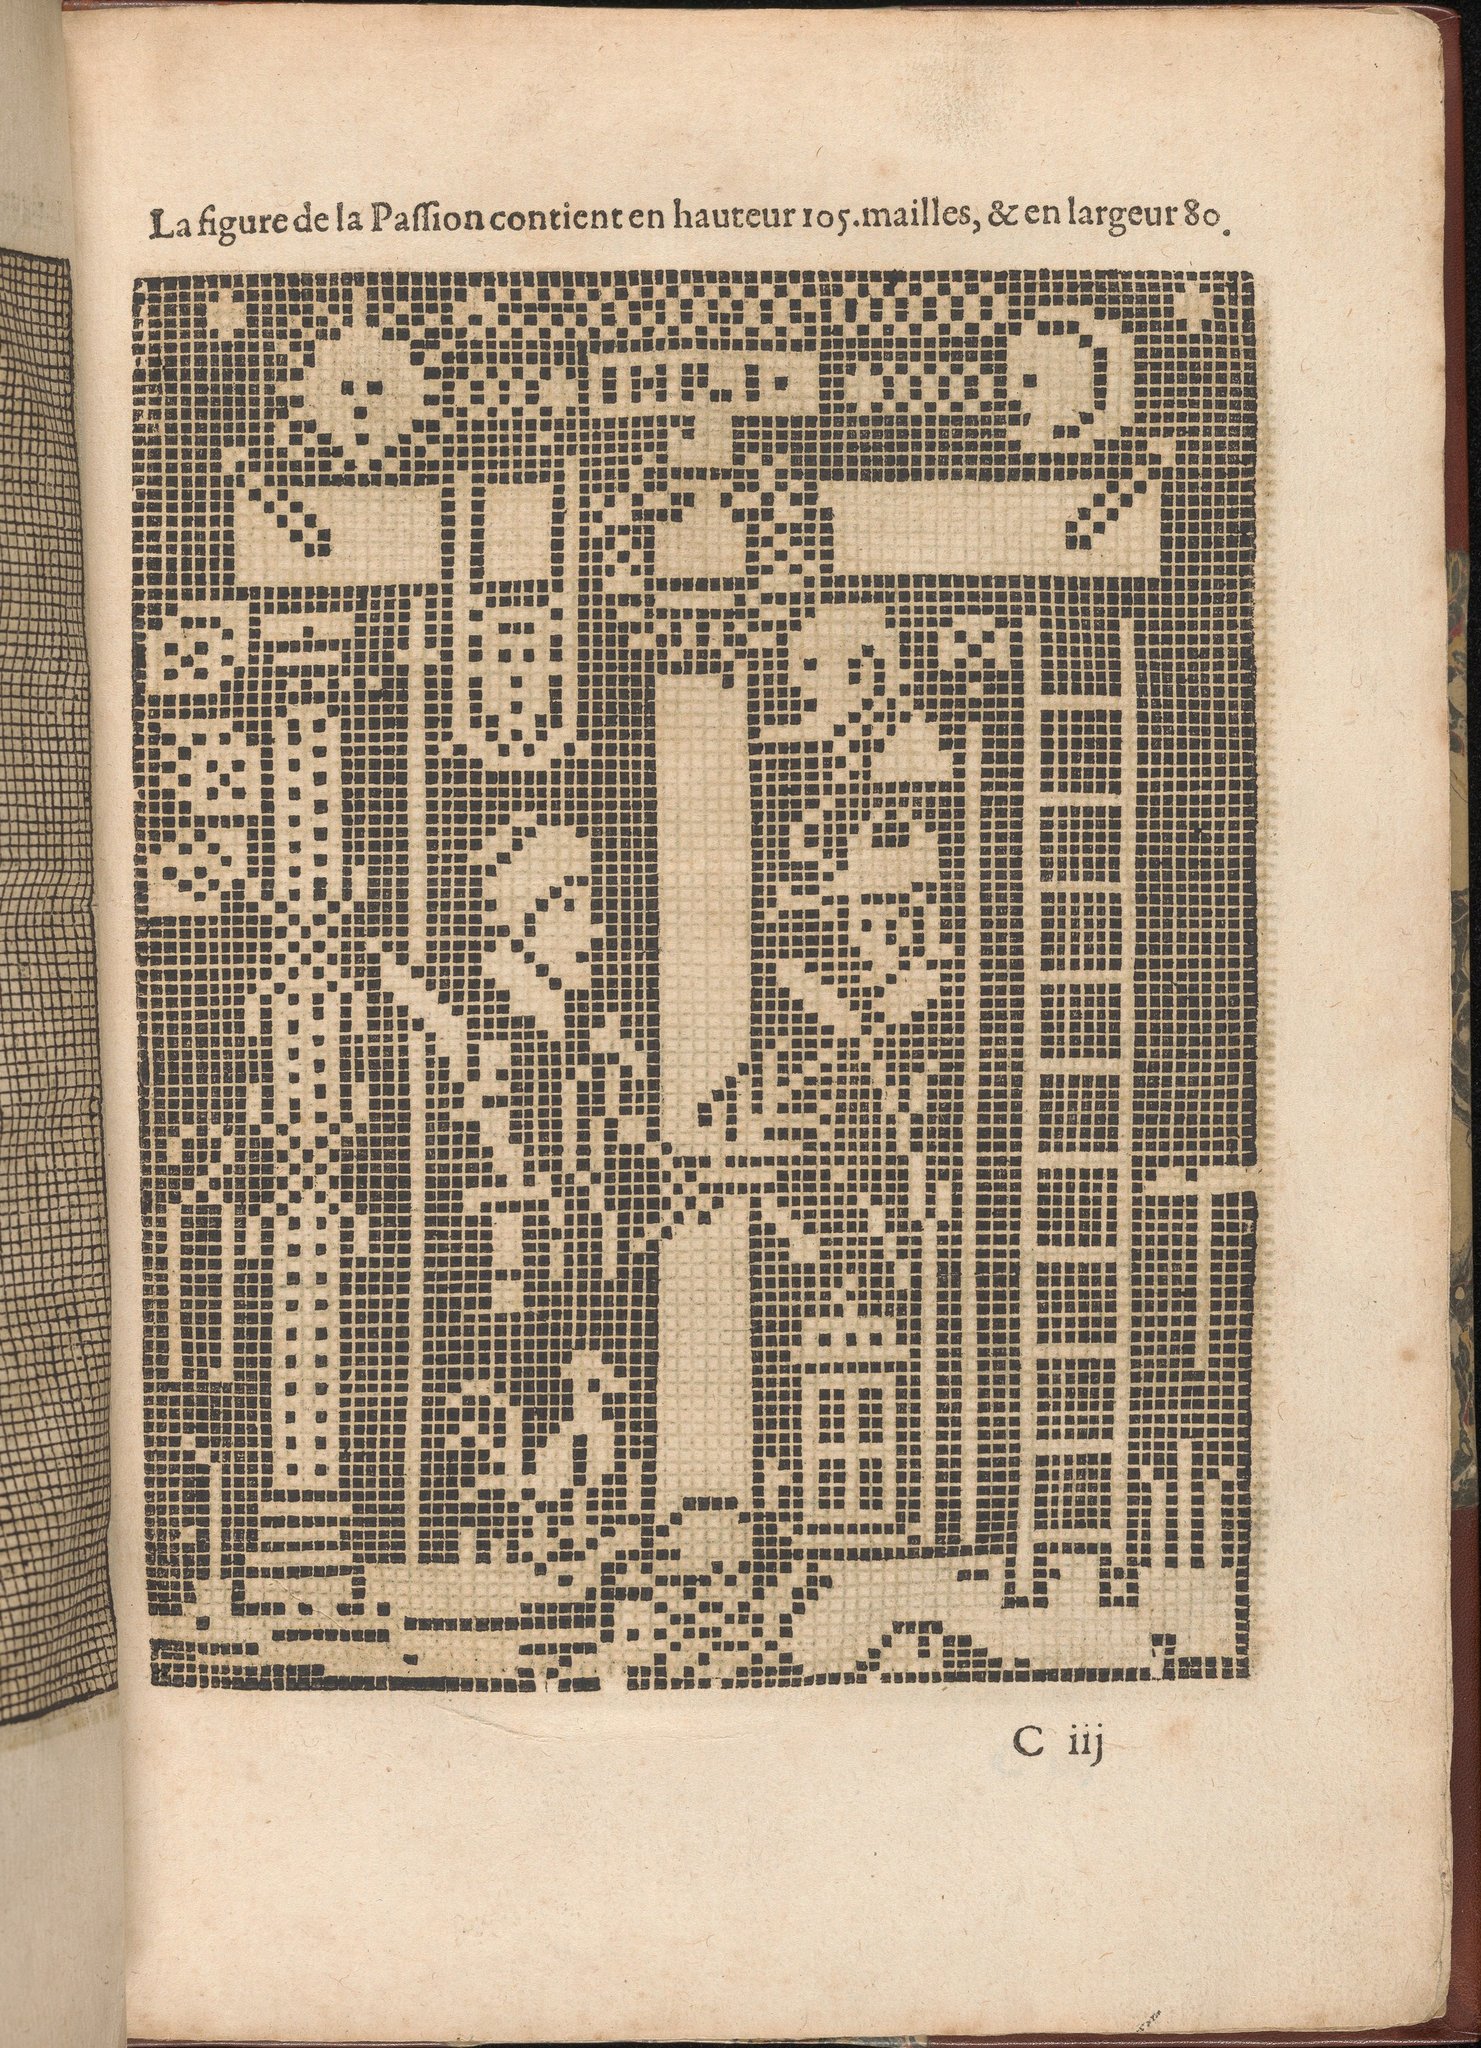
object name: book print ornament architecture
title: Les Secondes Oeuvres, et Subtiles Inventions De Lingerie du Seigneur Federic de Vinciolo Venitien, page 11 (recto)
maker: federico de vinciolo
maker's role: designer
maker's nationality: italian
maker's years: 1582-1599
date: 1603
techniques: woodcut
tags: heads,roosters,cross,ladders